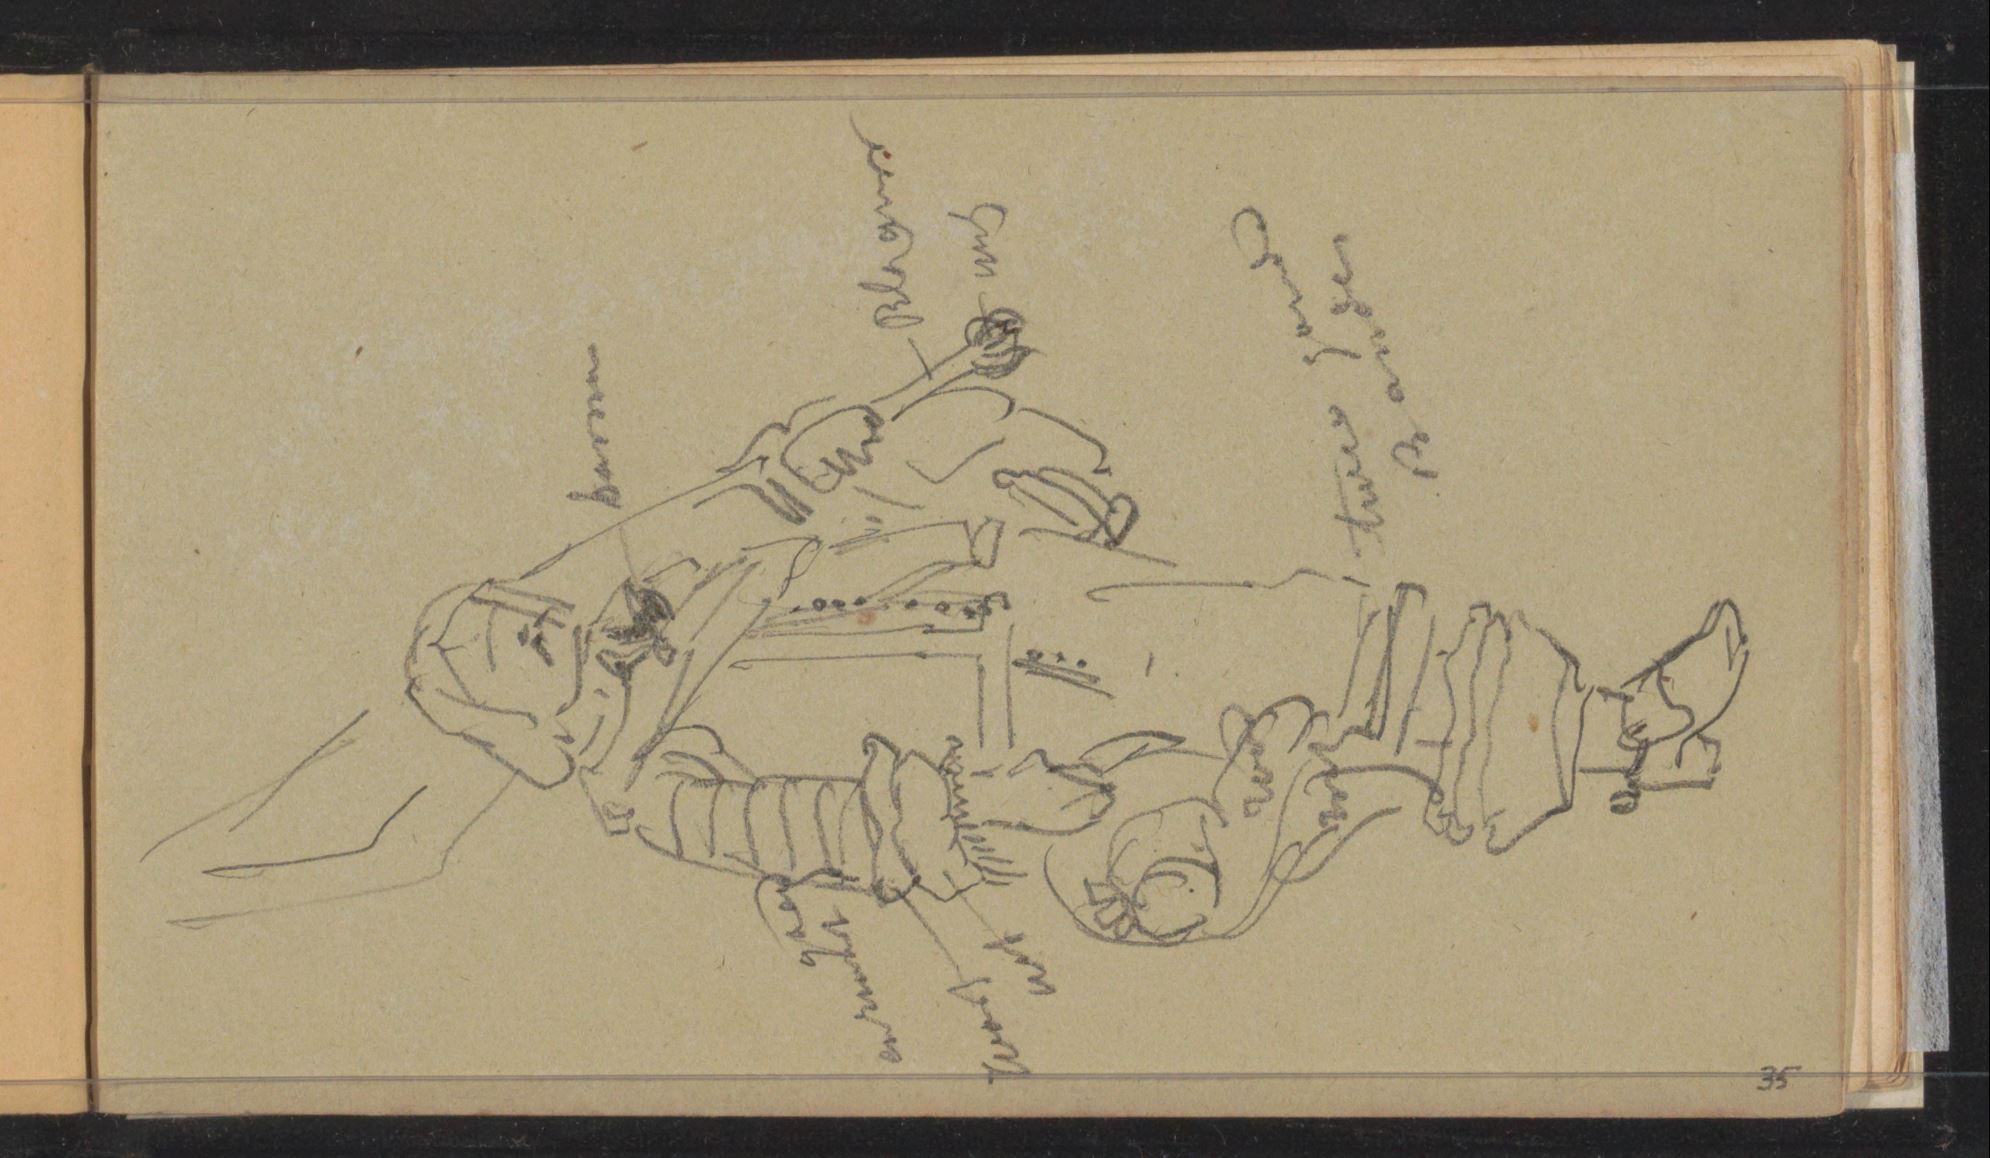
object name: sketchbook leaf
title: Man in zeventiende-eeuwse kleding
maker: cornelis springer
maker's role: draughtsman, painter, print maker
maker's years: 1817-1891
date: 1860-1866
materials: paper, pencil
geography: netherlands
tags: adult man, head-gear: hat (+ men's clothes)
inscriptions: kleurnotitie, handgeschreven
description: Man in zeventiende-eeuwse kleding. In zijn rechterhand heeft hij een hoed. Over zijn linkerschouder mogelijk een vlag of vaandel. Blad 35 uit een schetsboek met 44 bladen.